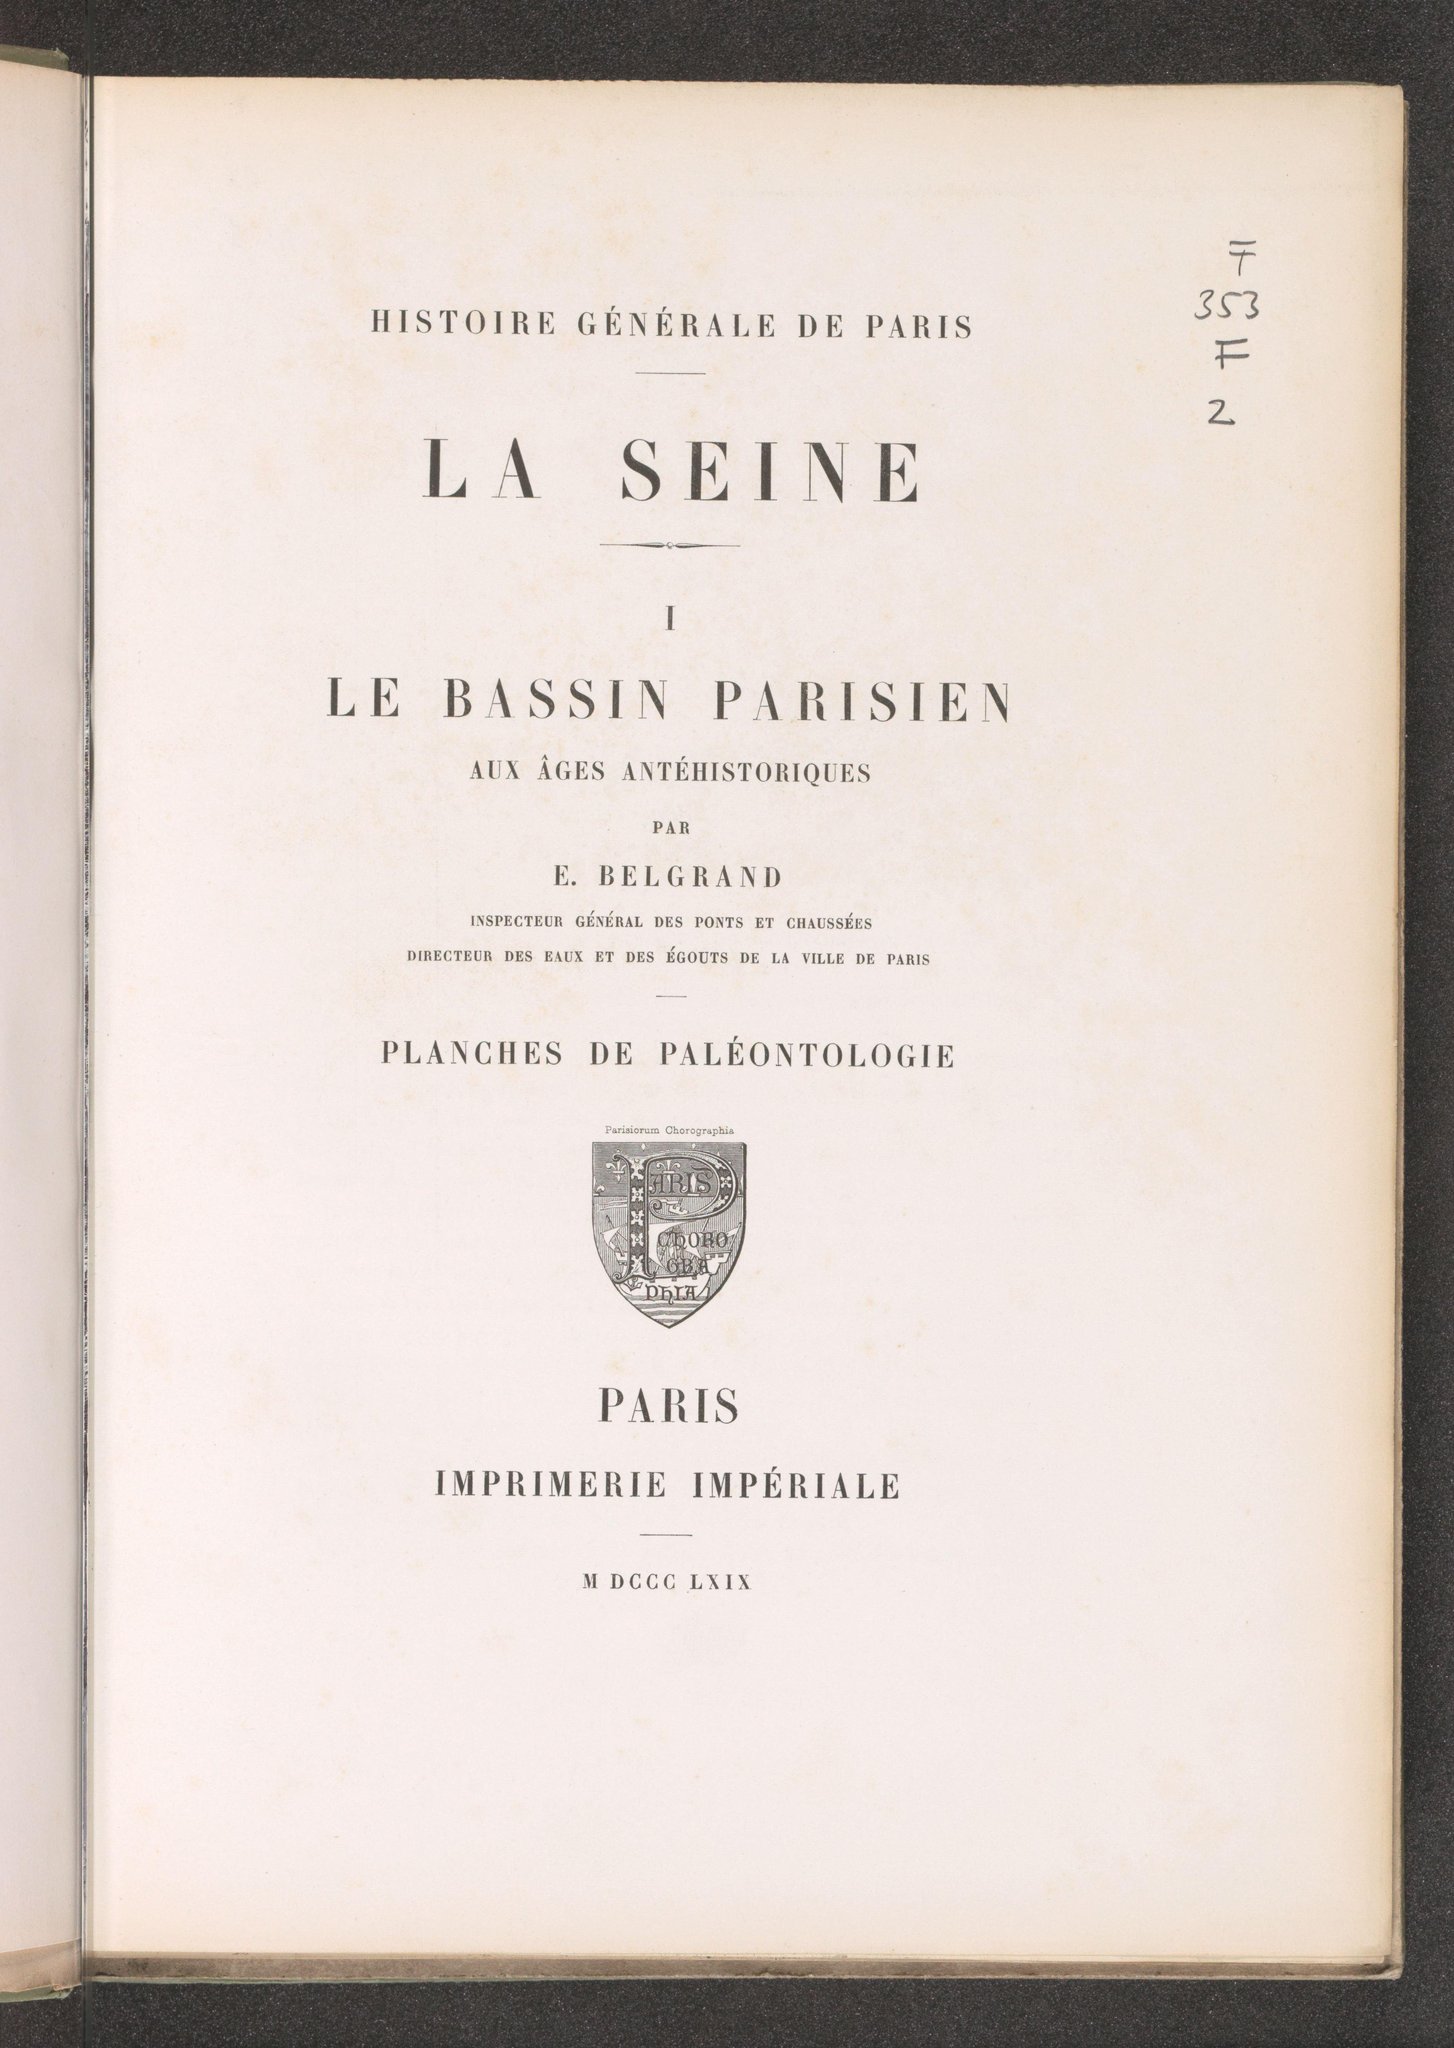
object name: book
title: La Seine: I. Le bassin parisien aux âges anthéhistoriques (planches de paléontologie)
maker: eugène belgrand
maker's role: engineer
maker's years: 1810-1878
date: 1869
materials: cardboard, paper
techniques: photoaquatint, photolithography, printing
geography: paris